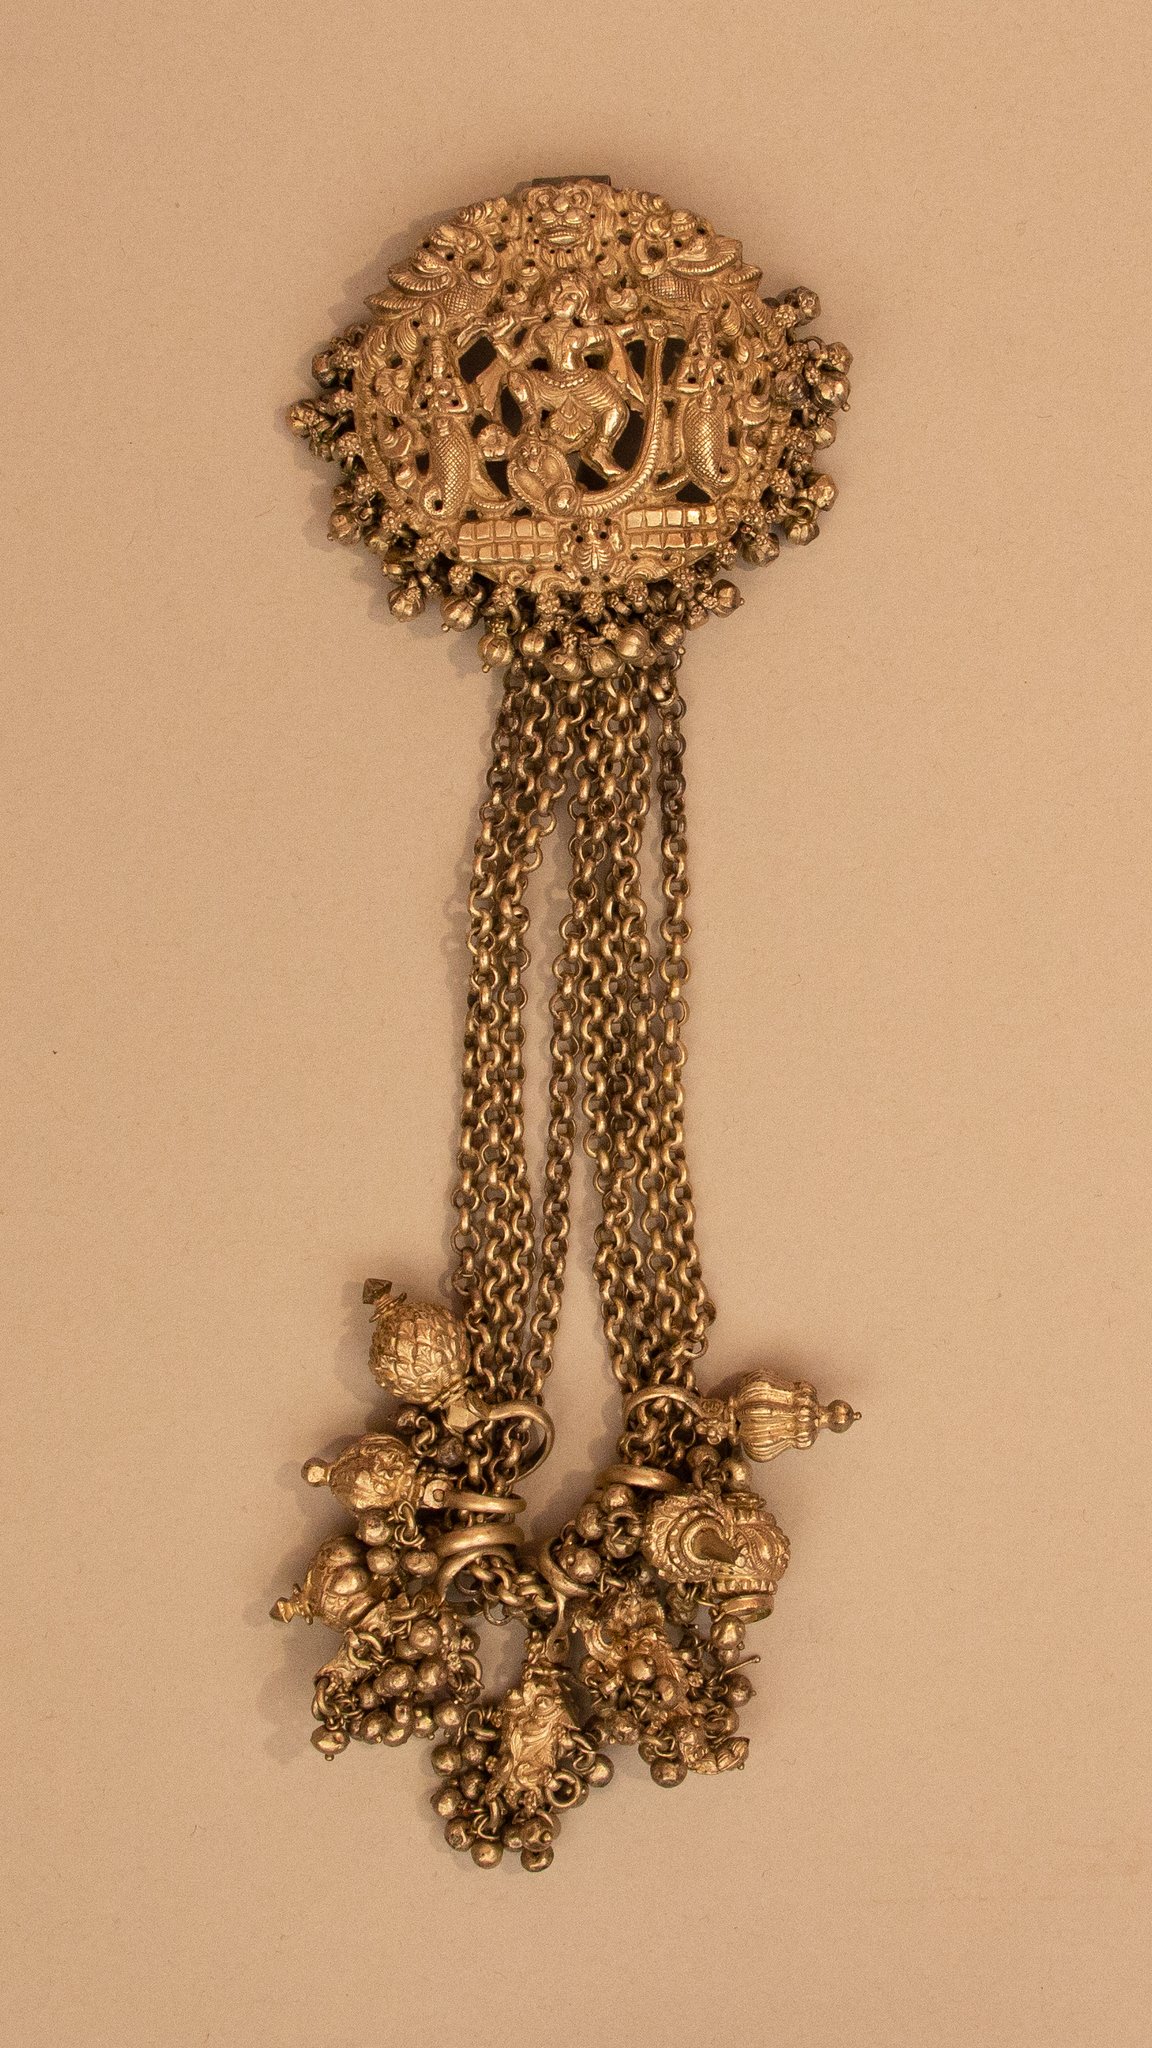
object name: chatelaine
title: Châtelaine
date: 1601-1900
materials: silver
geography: india